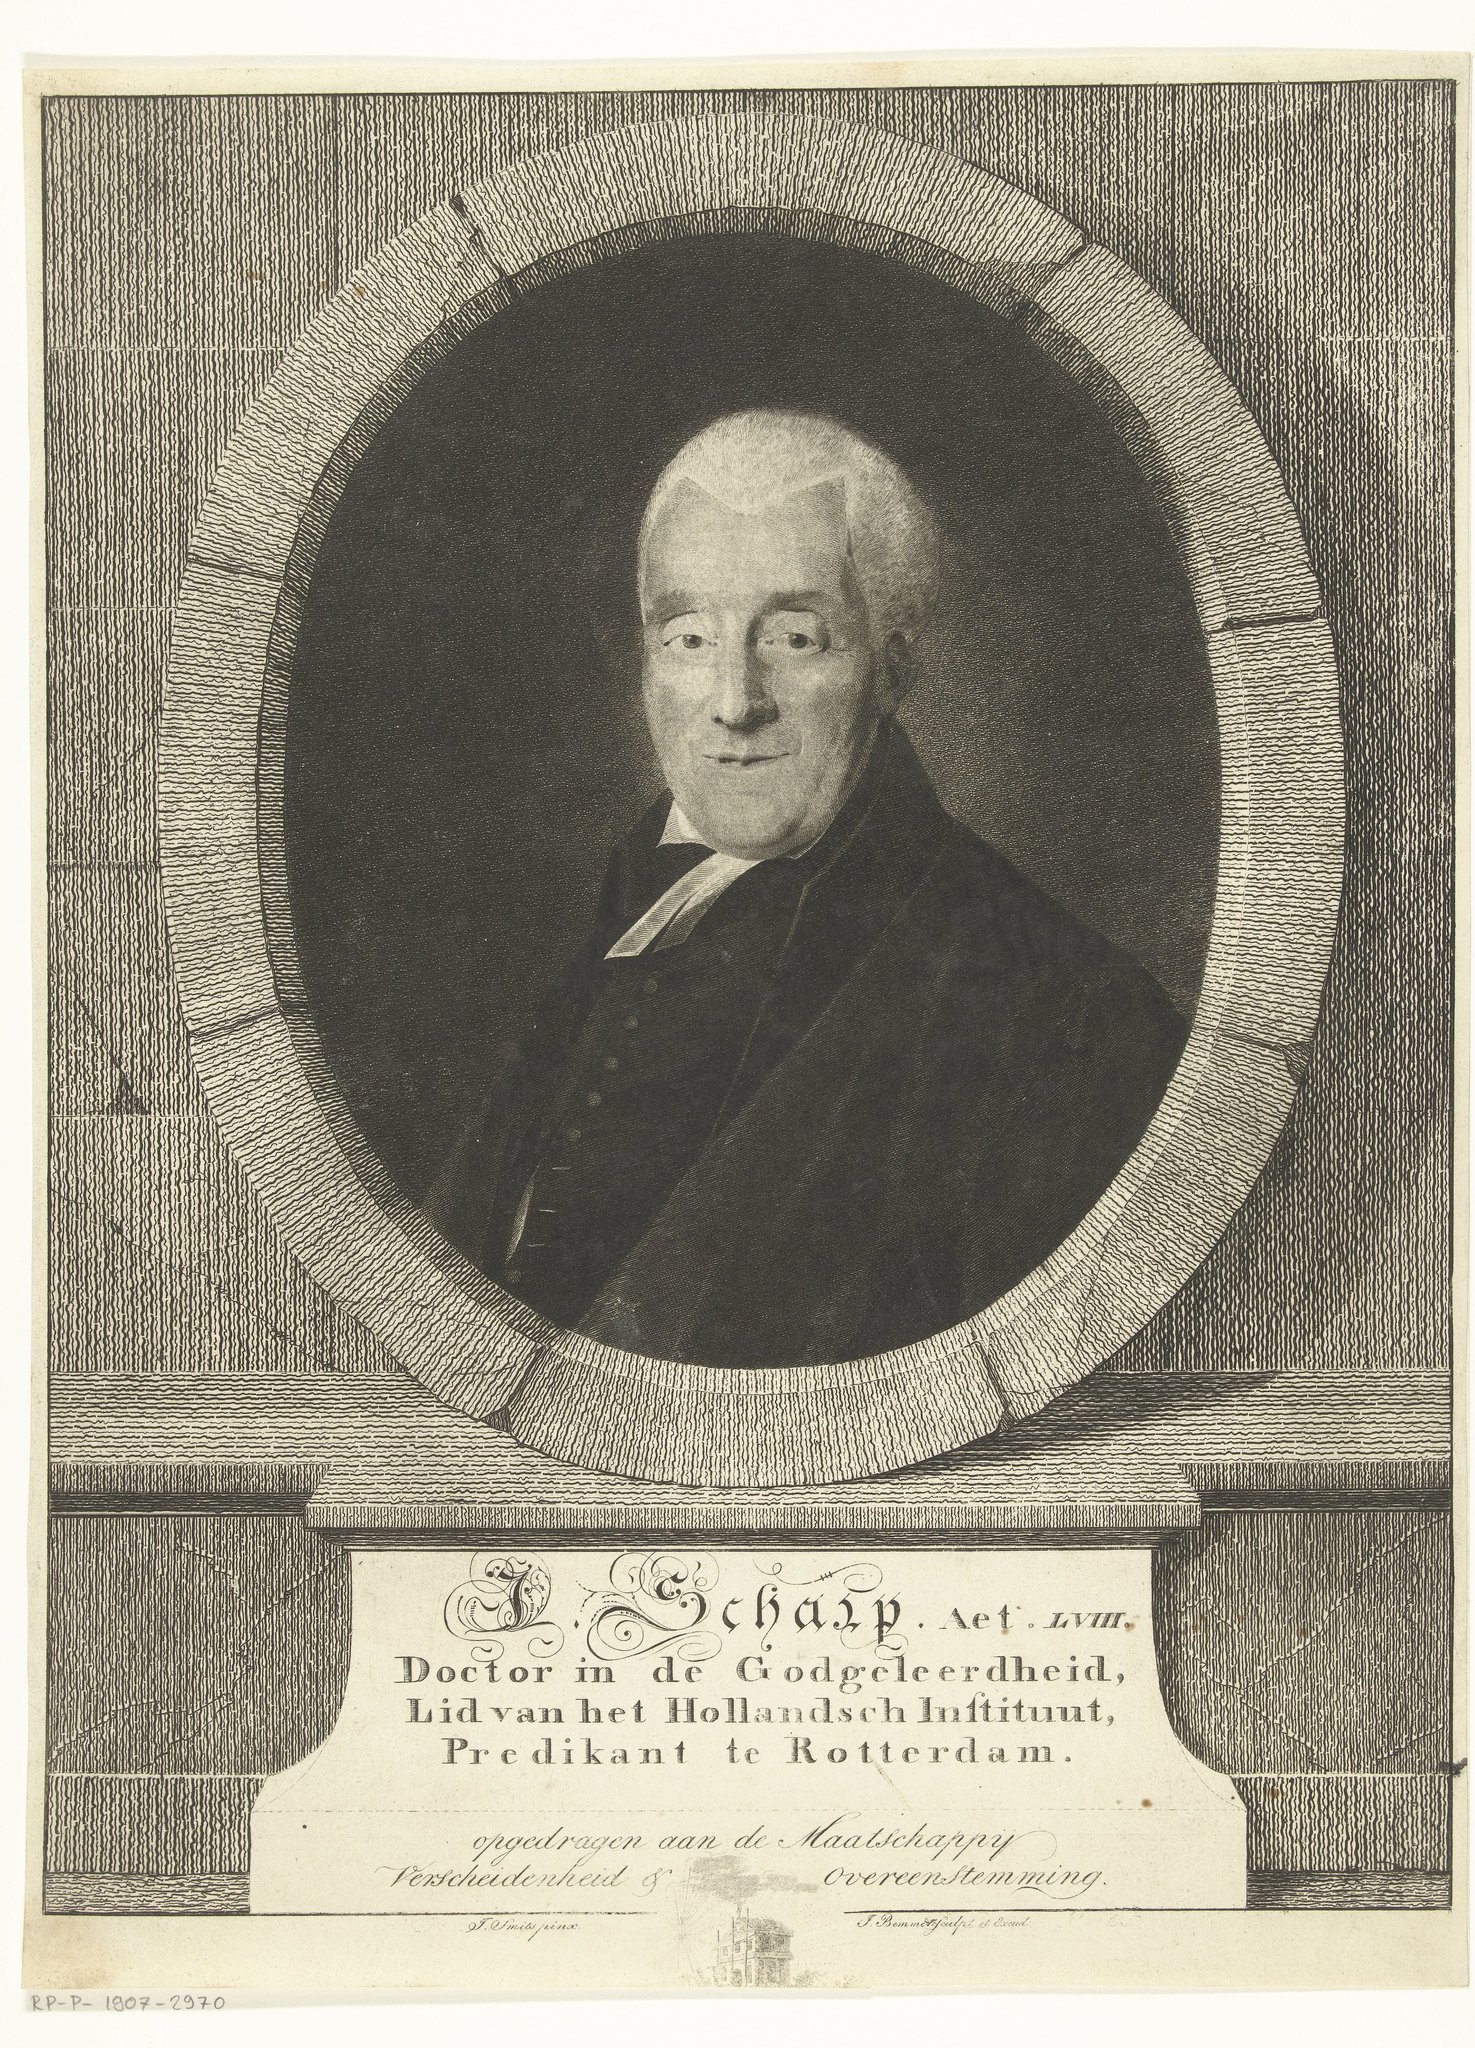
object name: print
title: Portret van Jan Scharp op 58-jarige leeftijd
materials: paper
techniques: etching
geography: rotterdam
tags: the hague, rotterdam, jan scharp, functionaries and dignitaries ~ protestant churches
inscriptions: collector's mark: Lugt 2166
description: Portret van de oranjegezinde predikant Jan Scharp op 58-jarige leeftijd, in ovaal naar links. Onder het portret zijn naam en functie.